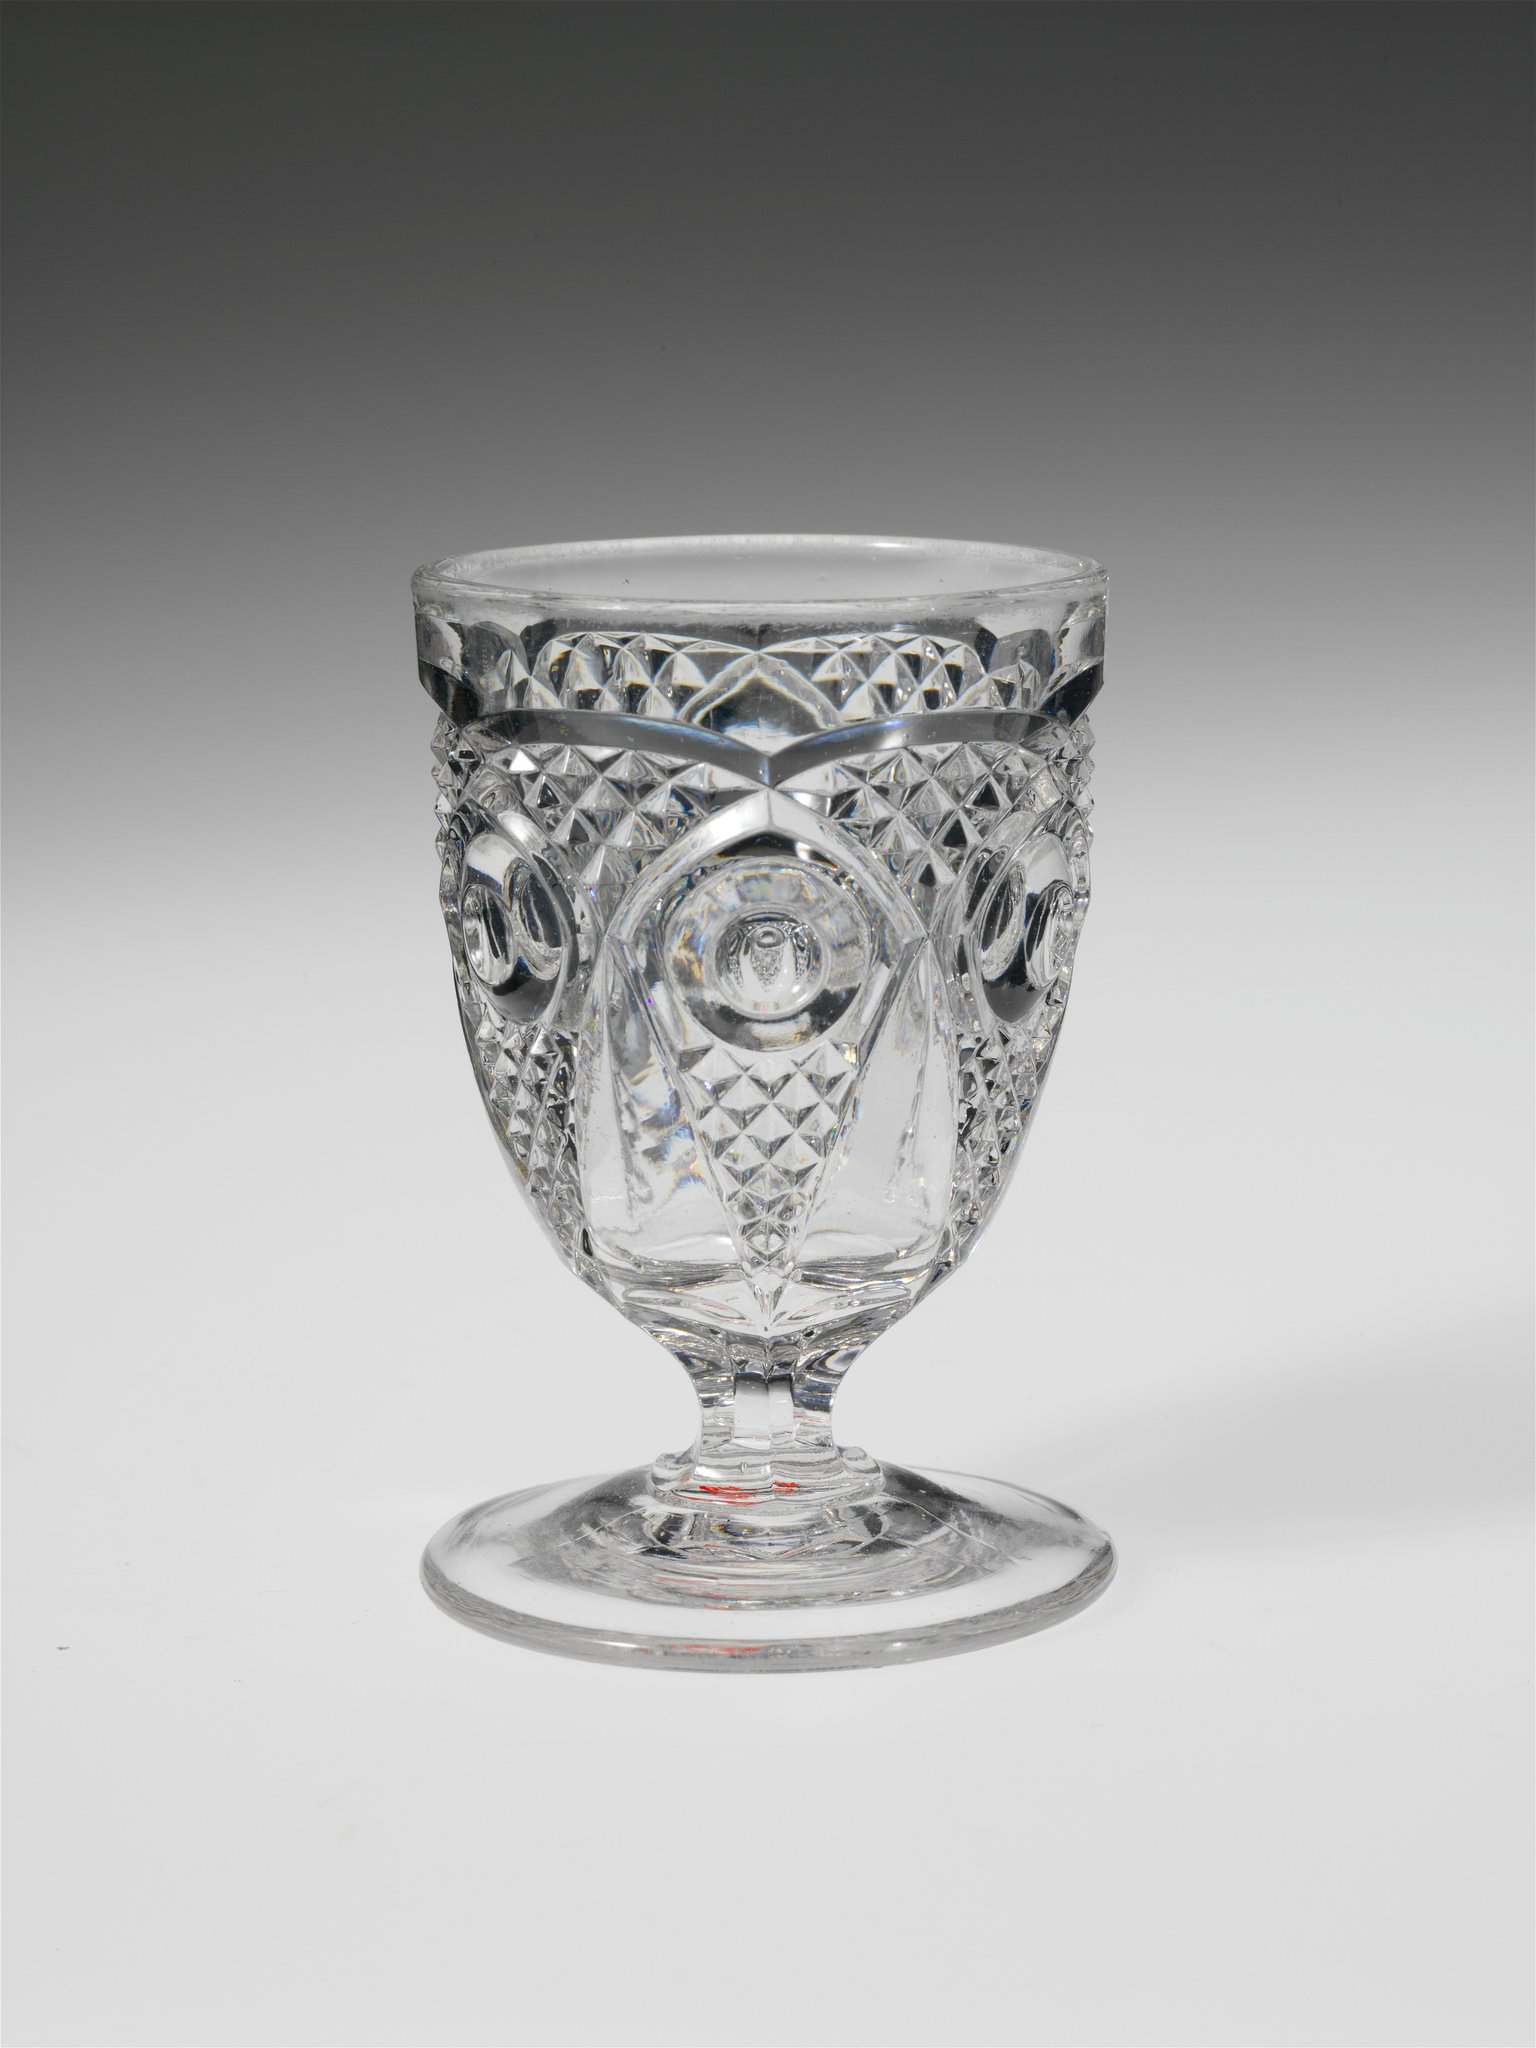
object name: egg cup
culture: american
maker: new england glass company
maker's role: maker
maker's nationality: american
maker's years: 1818-1888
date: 1860-1870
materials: glass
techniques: pressed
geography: united states